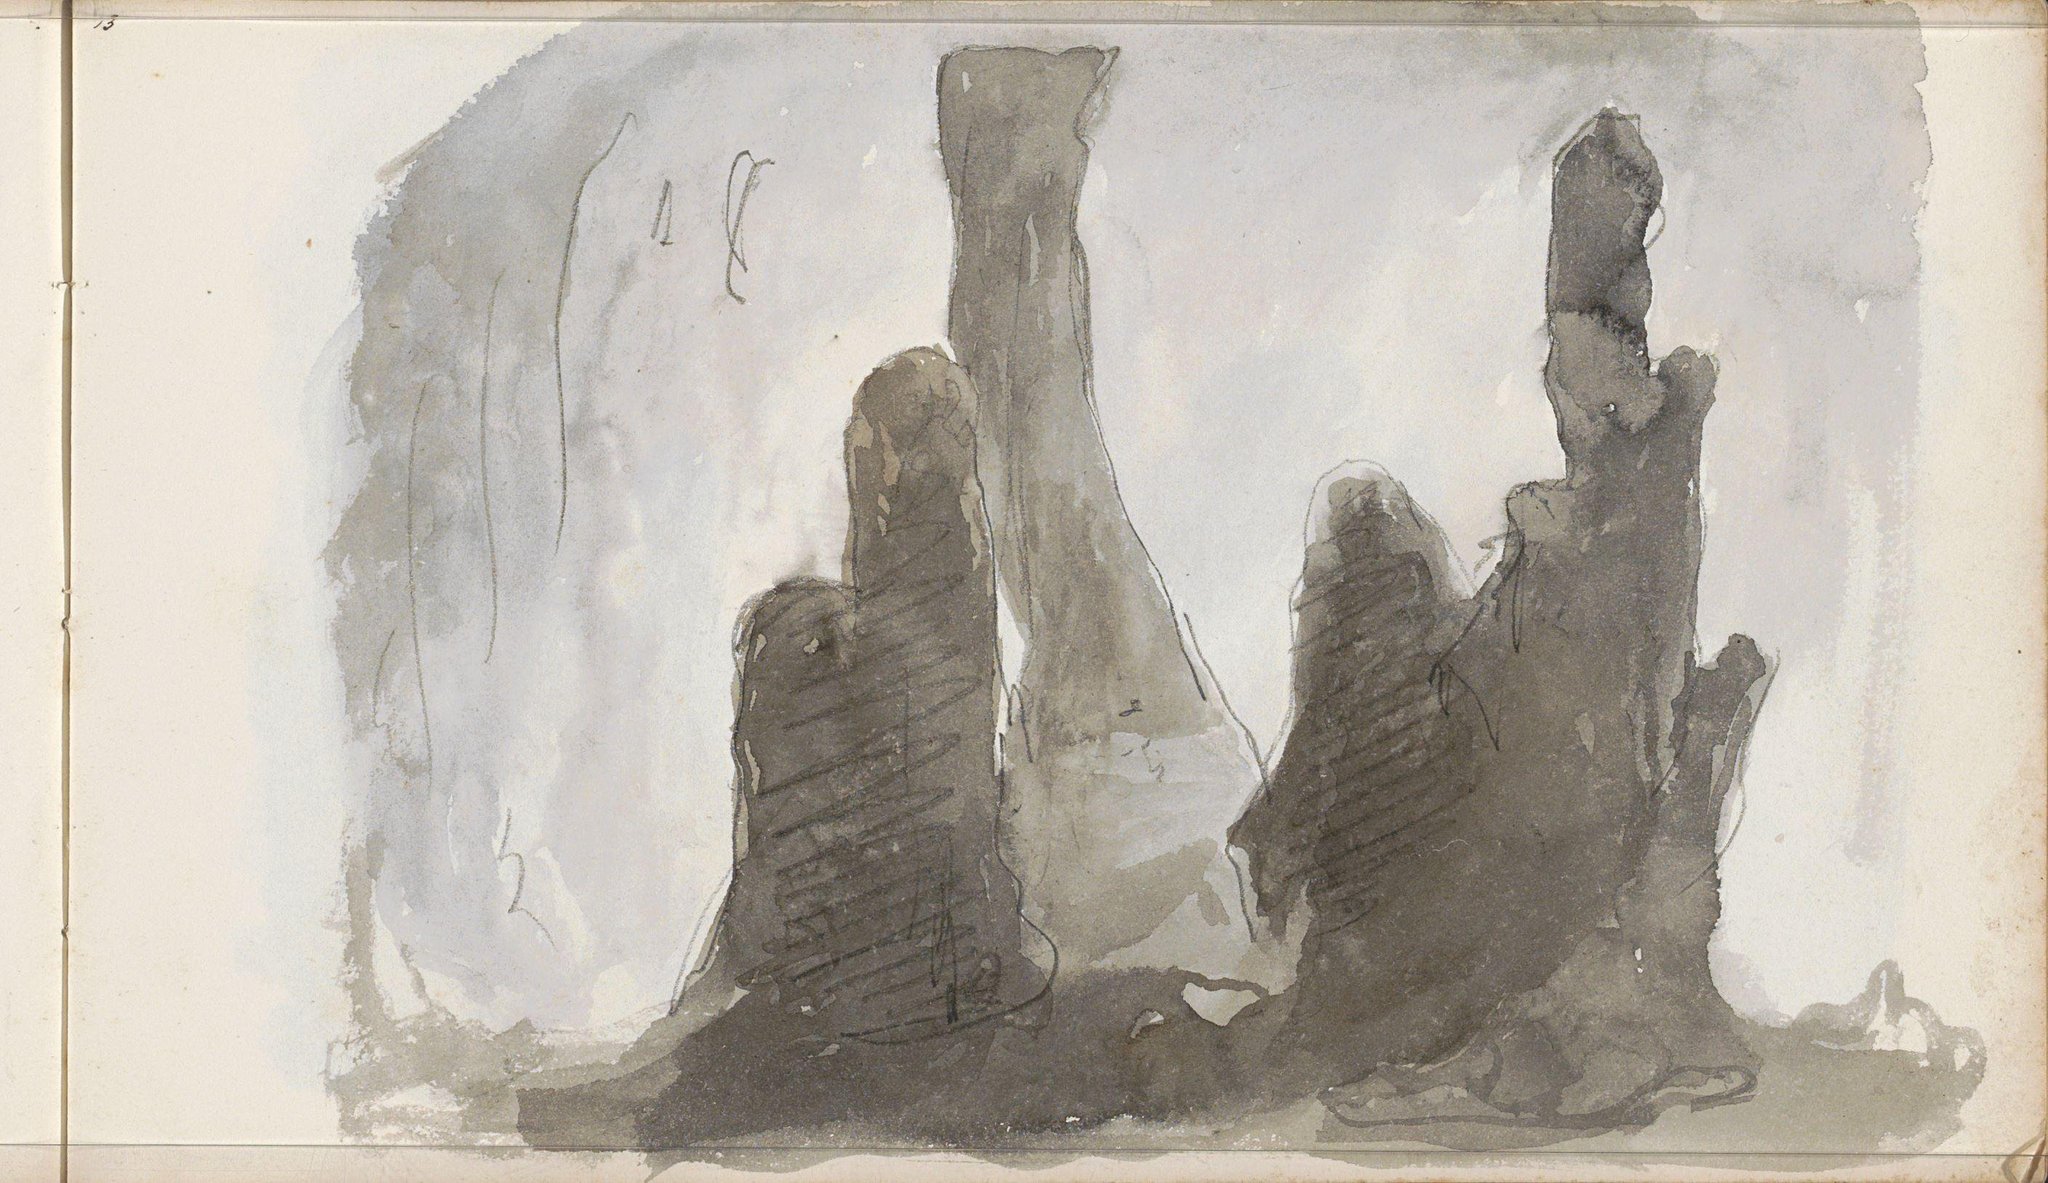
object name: sketchbook leaf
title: Stalagmieten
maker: petrus johannes schotel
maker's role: draughtsman, painter, print maker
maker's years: 1808-1865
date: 1841-1865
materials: paper, pencil, watercolor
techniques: brush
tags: cave, grotto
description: Pagina 13 uit een schetsboek met 80 pagina's.